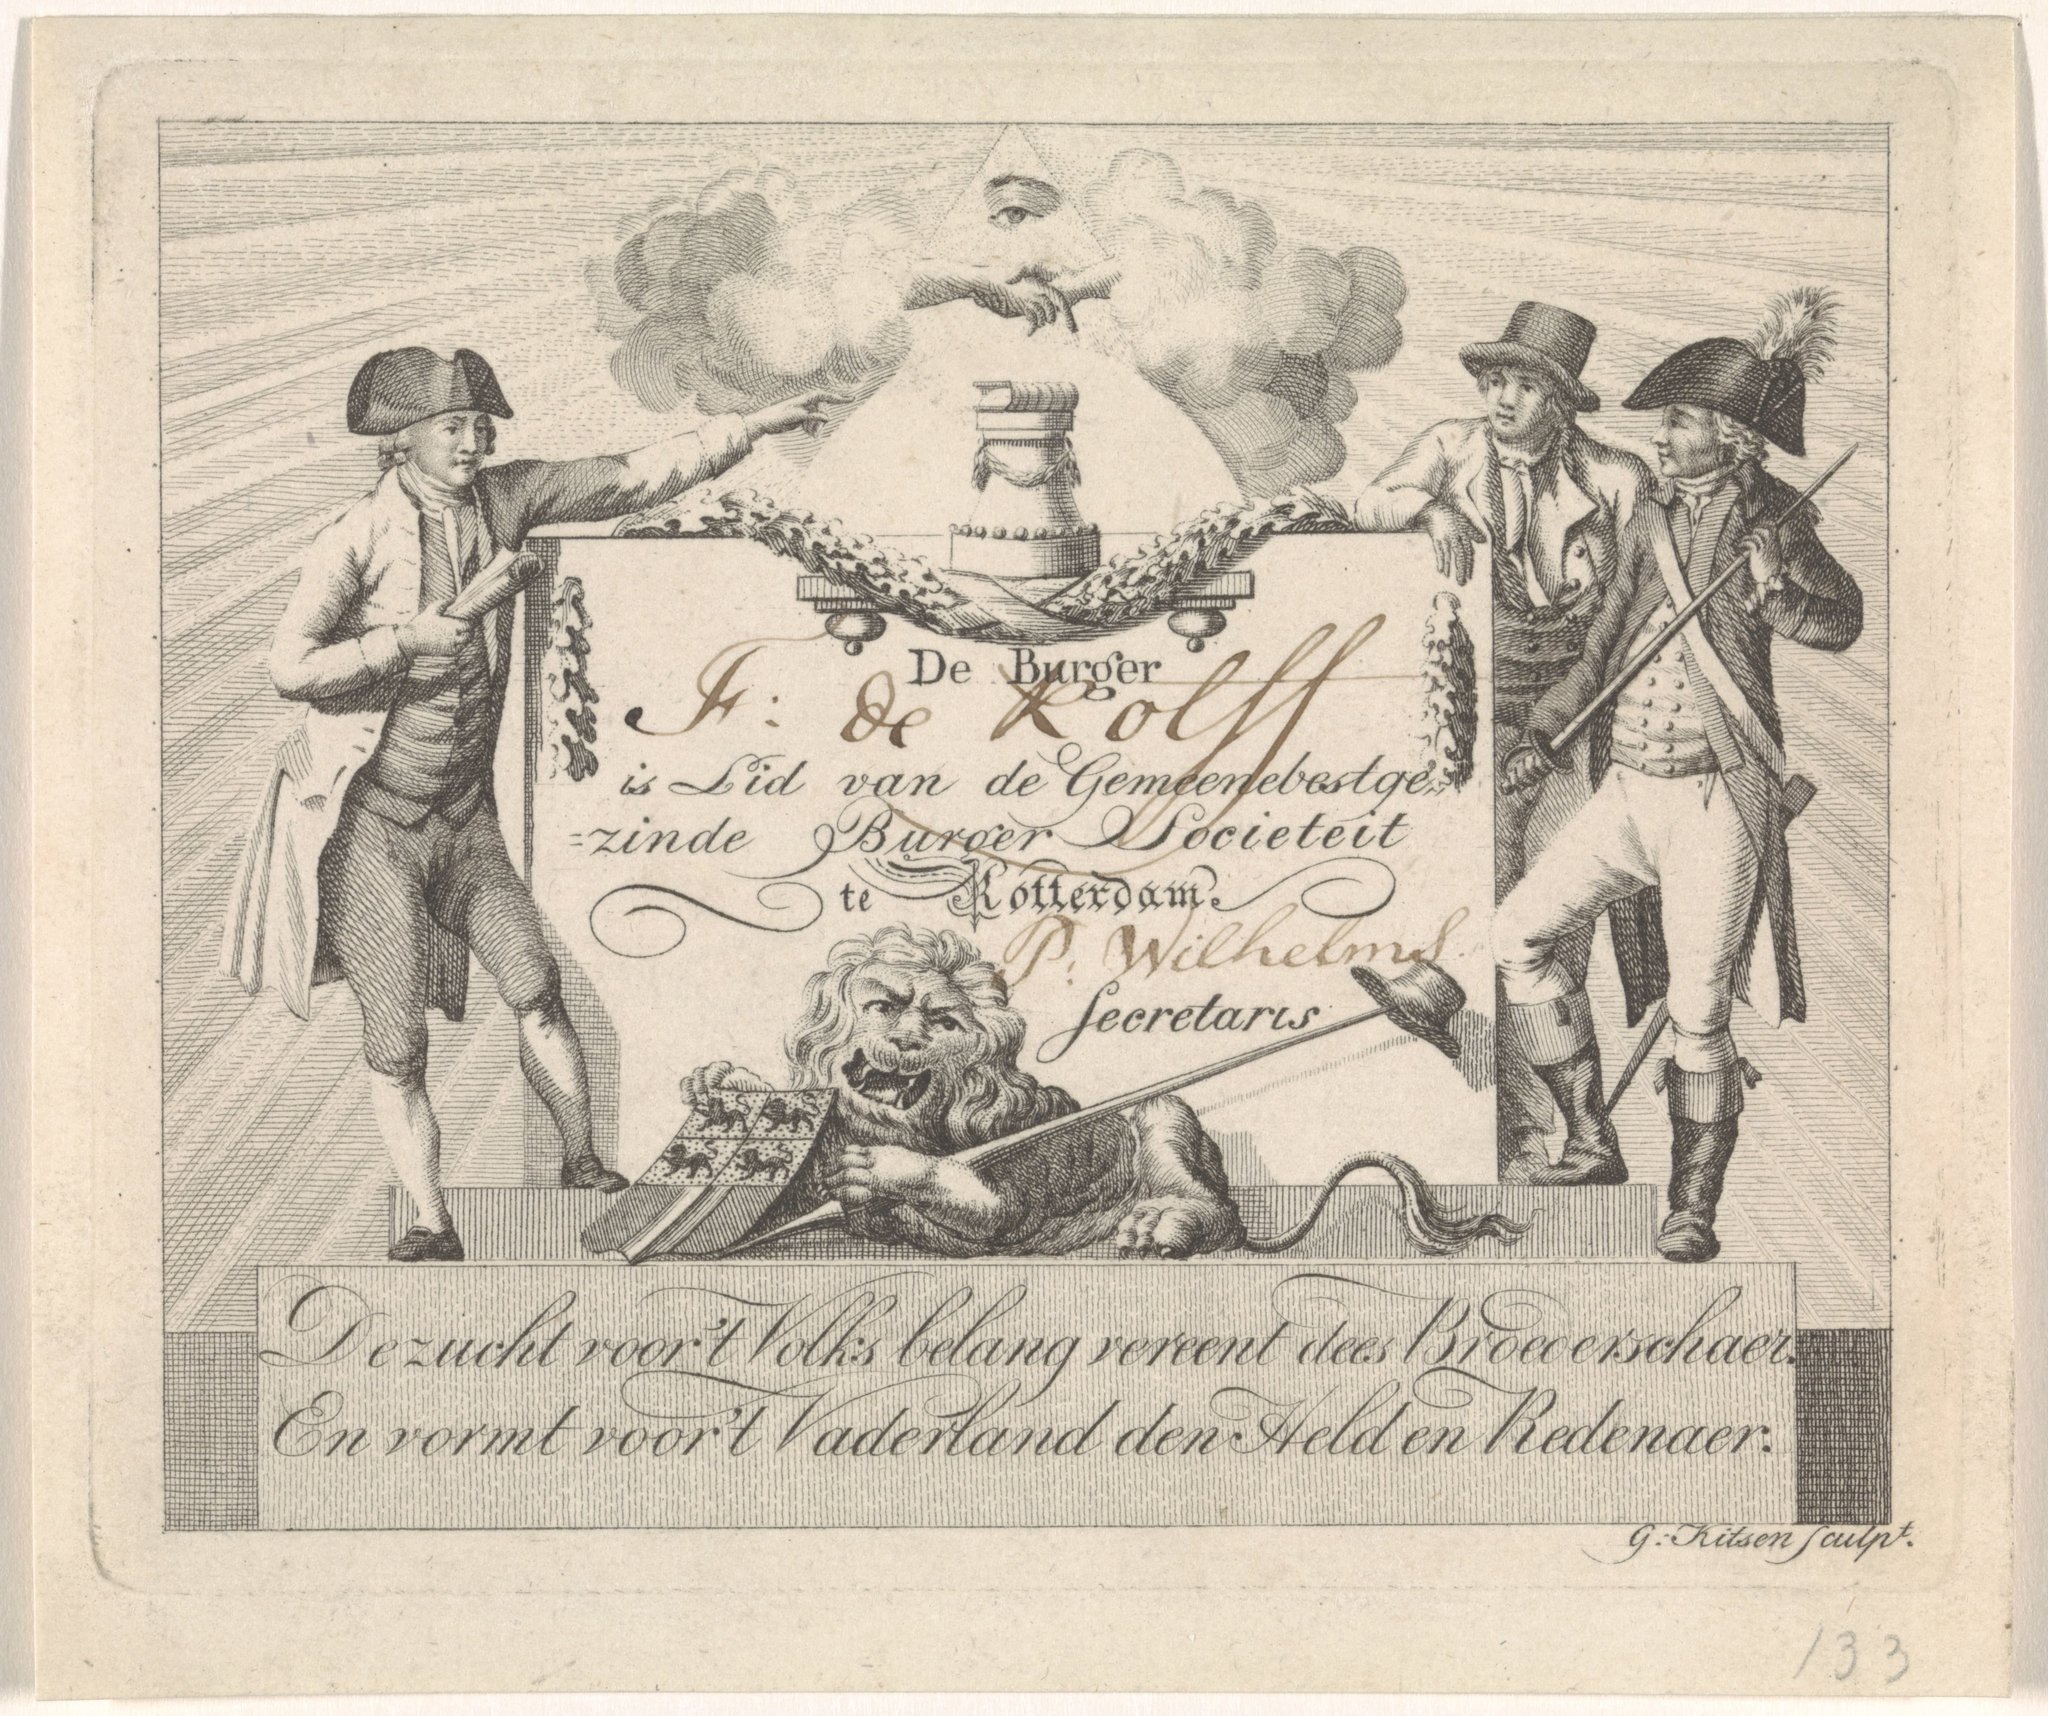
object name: print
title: Lidmaatschapskaart voor Gemeenebestgezinde Burger Societeit te Rotterdam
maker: govert kitsen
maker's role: print maker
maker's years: 1766-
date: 1776-1810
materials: paper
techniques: etching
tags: soldiers and civilians, beasts of prey, predatory animals: lion, triangle (within circle), with eye or tetragram ~ trinity, freedom, liberty; 'libertà' (ripa) (+ symbolical representation of concept), rotterdam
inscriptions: collector's mark: ‘Fr. M. No. 4639B’, inscription: ‘F: De Rolff P: Wilhelmus’, collector's mark: Lugt 2228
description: Lidmaatschapskaart van F. de Rolff voor de 'Gemeenebestgezinde Burger Societeit' te Rotterdam, getekend door de secretaris van de sociëteit. Boven de handtekeningen de triniteit. Onder de handtekening van De Rolff en de secretaris ligt een brullende leeuw met een wapenschild en vrijheidspaal. Onder de leeuw een tweeregelige Nederlandse tekst, geflankeerd door burgers en een soldaat.